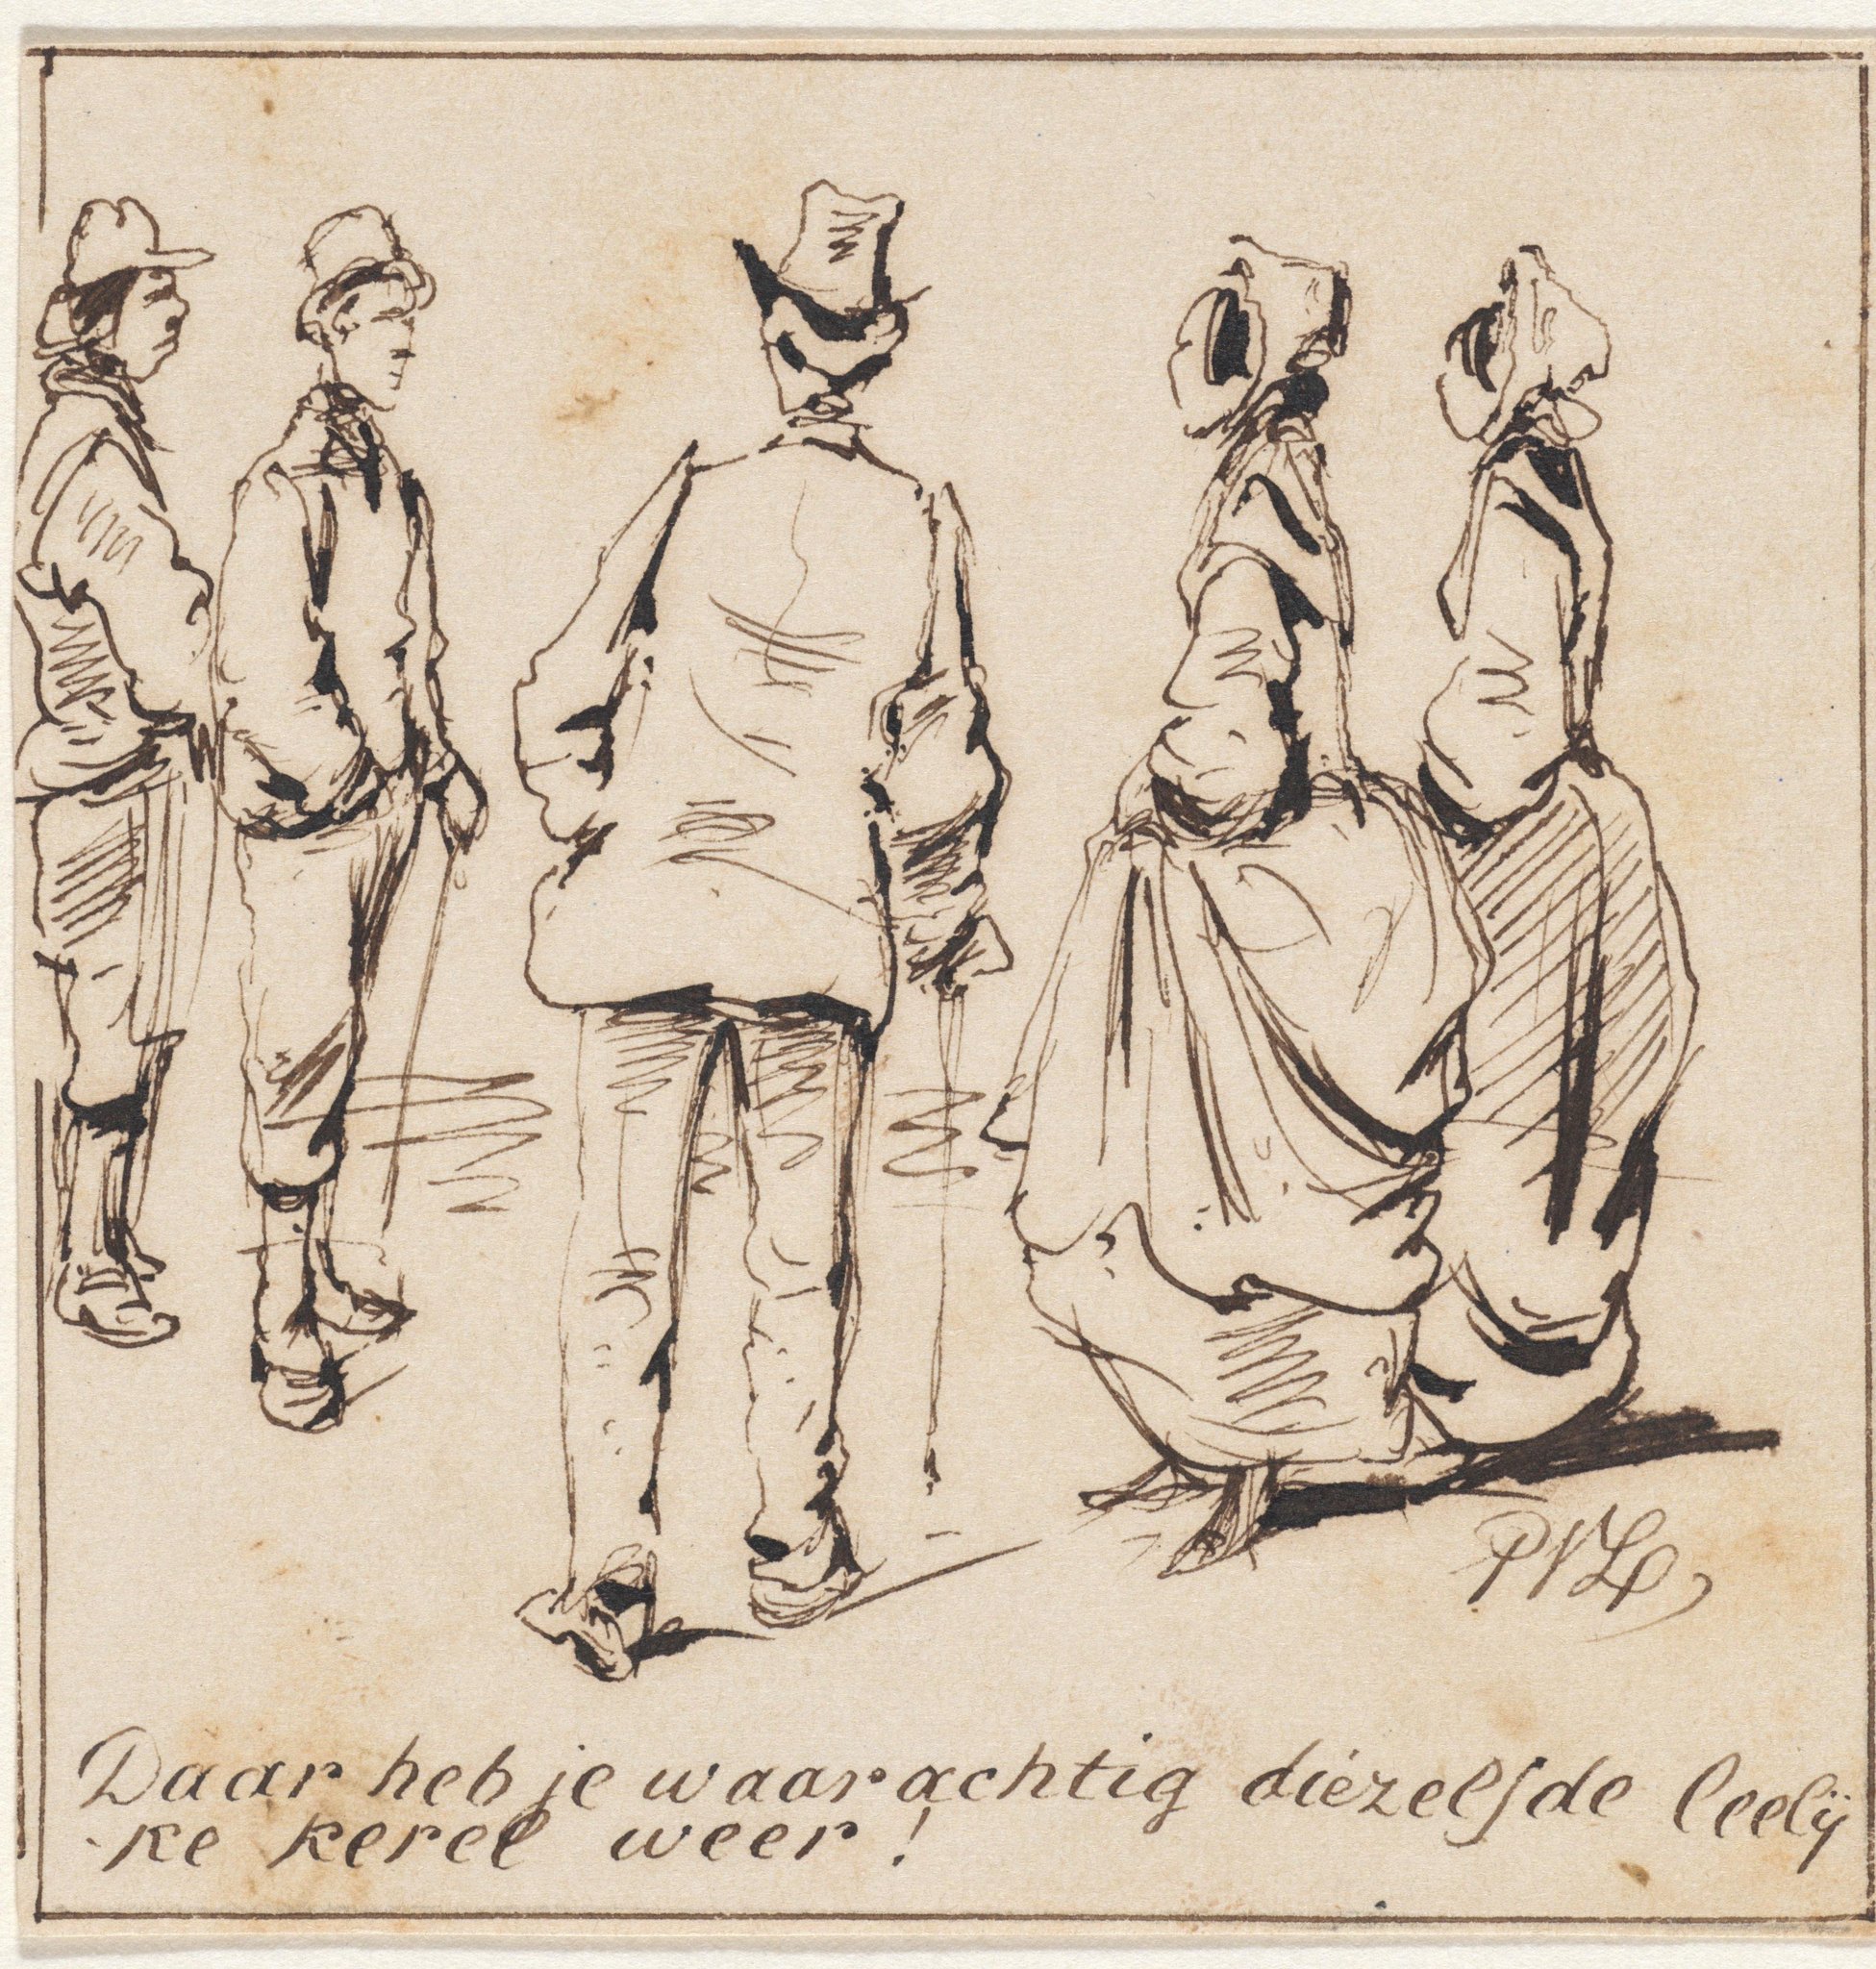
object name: drawing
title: Daar heb je waarachtig diezelfde leelijke kerel weer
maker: pieter van loon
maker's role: draughtsman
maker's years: 1801-1873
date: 1811-1873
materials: ink, paper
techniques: pen